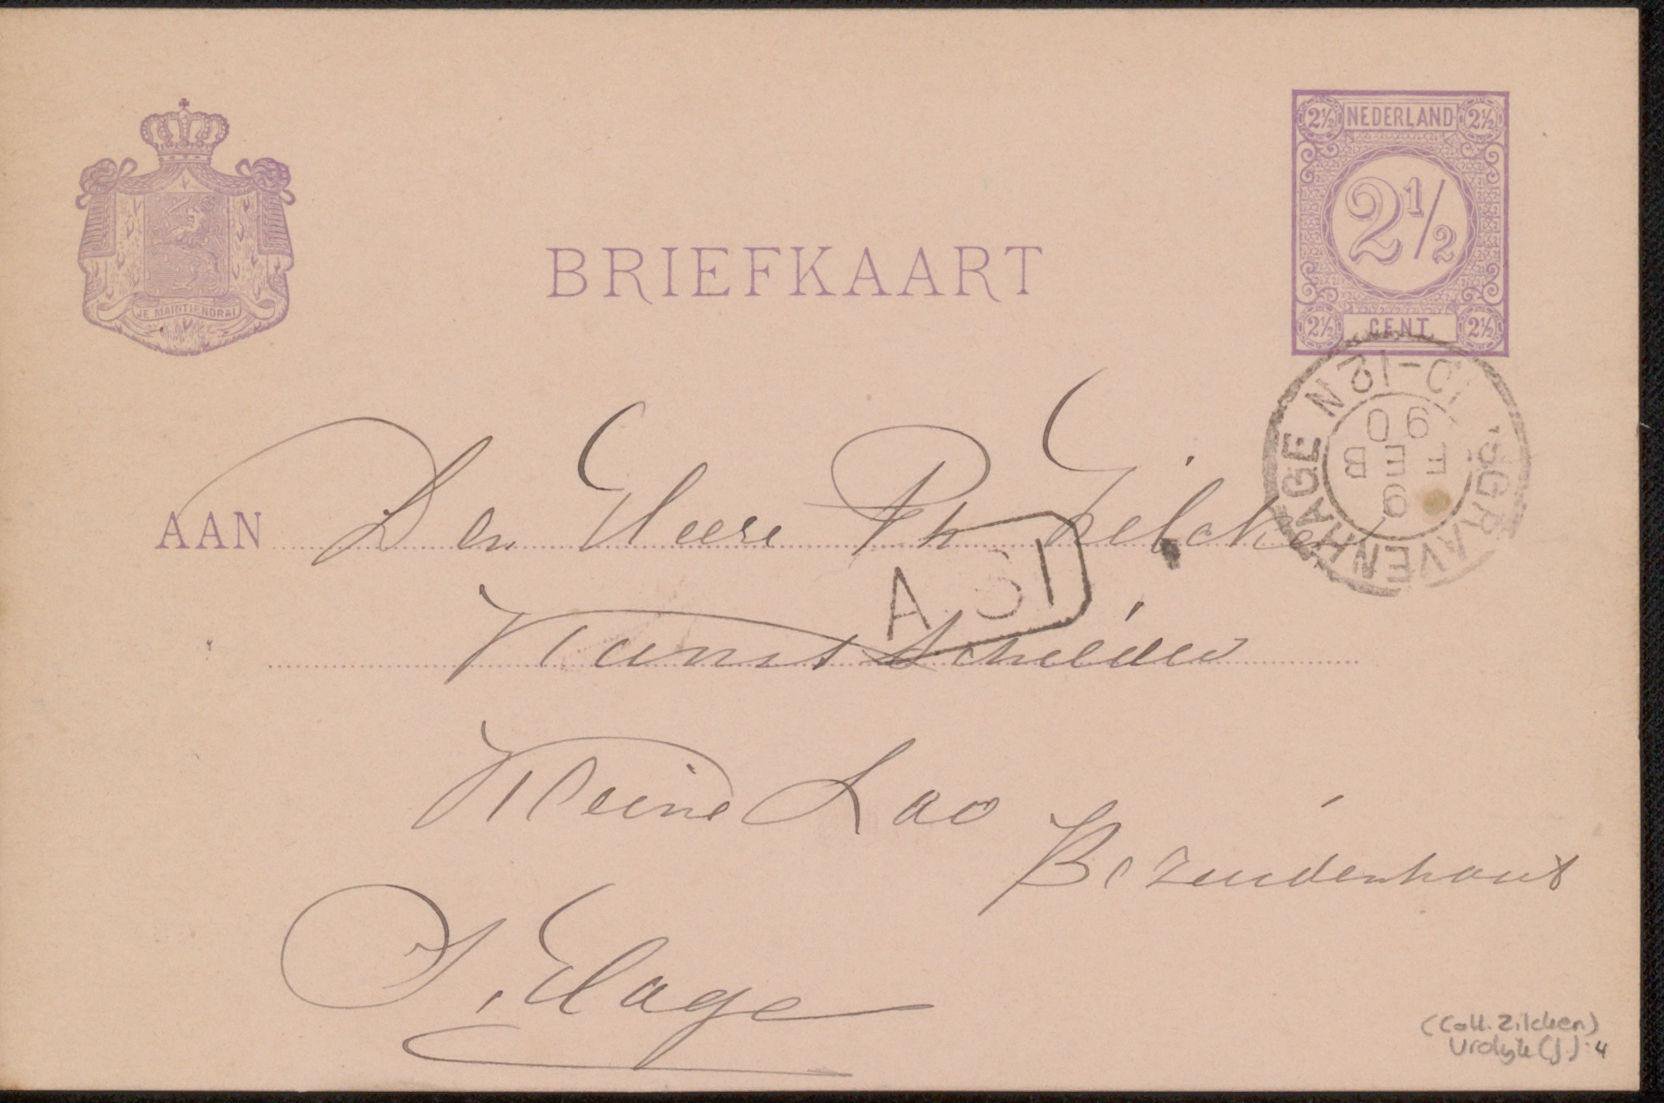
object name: postcard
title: Briefkaart aan Philip Zilcken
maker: jan vrolijk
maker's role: draughtsman, painter, print maker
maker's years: 1846-1894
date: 1890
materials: cardboard, ink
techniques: pen, writing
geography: the hague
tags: philip zilcken